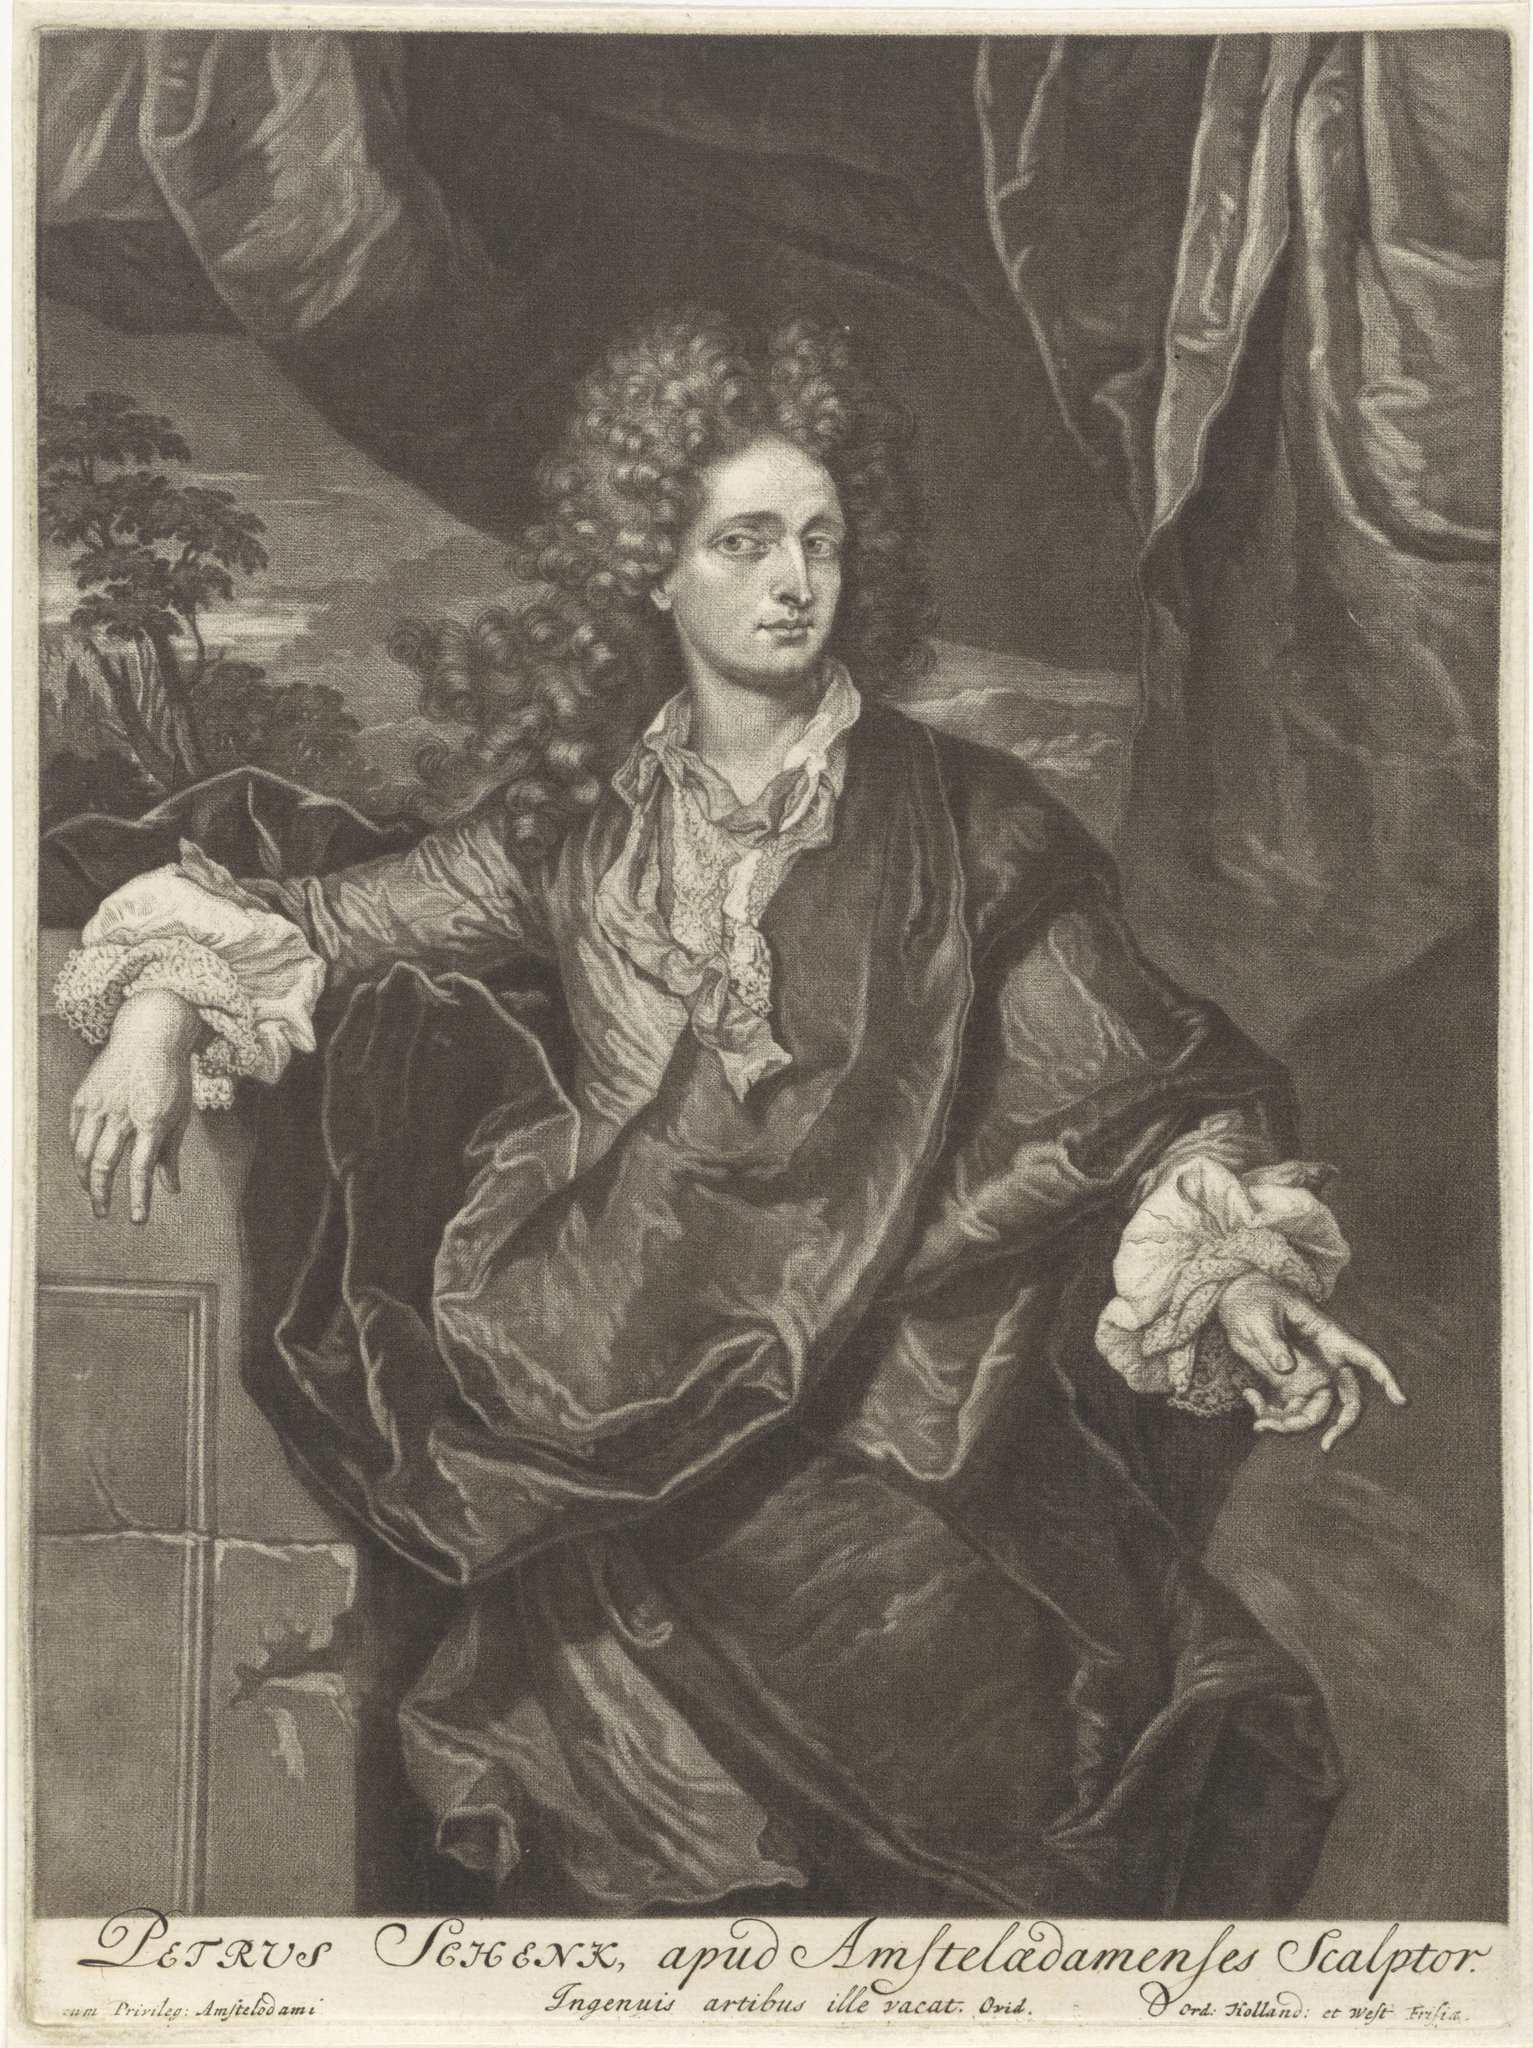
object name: print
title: Zelfportret van Pieter Schenk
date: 1680-1713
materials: paper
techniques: engraving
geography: amsterdam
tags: print maker, pieter schenk (i), portrait, self-portrait of painter, portrait, self-portrait of artist, wig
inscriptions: collector's mark: Lugt 964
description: De prentmaker en uitgever Pieter Schenk staat voor een draperie. Op de achtergrond een landschap.